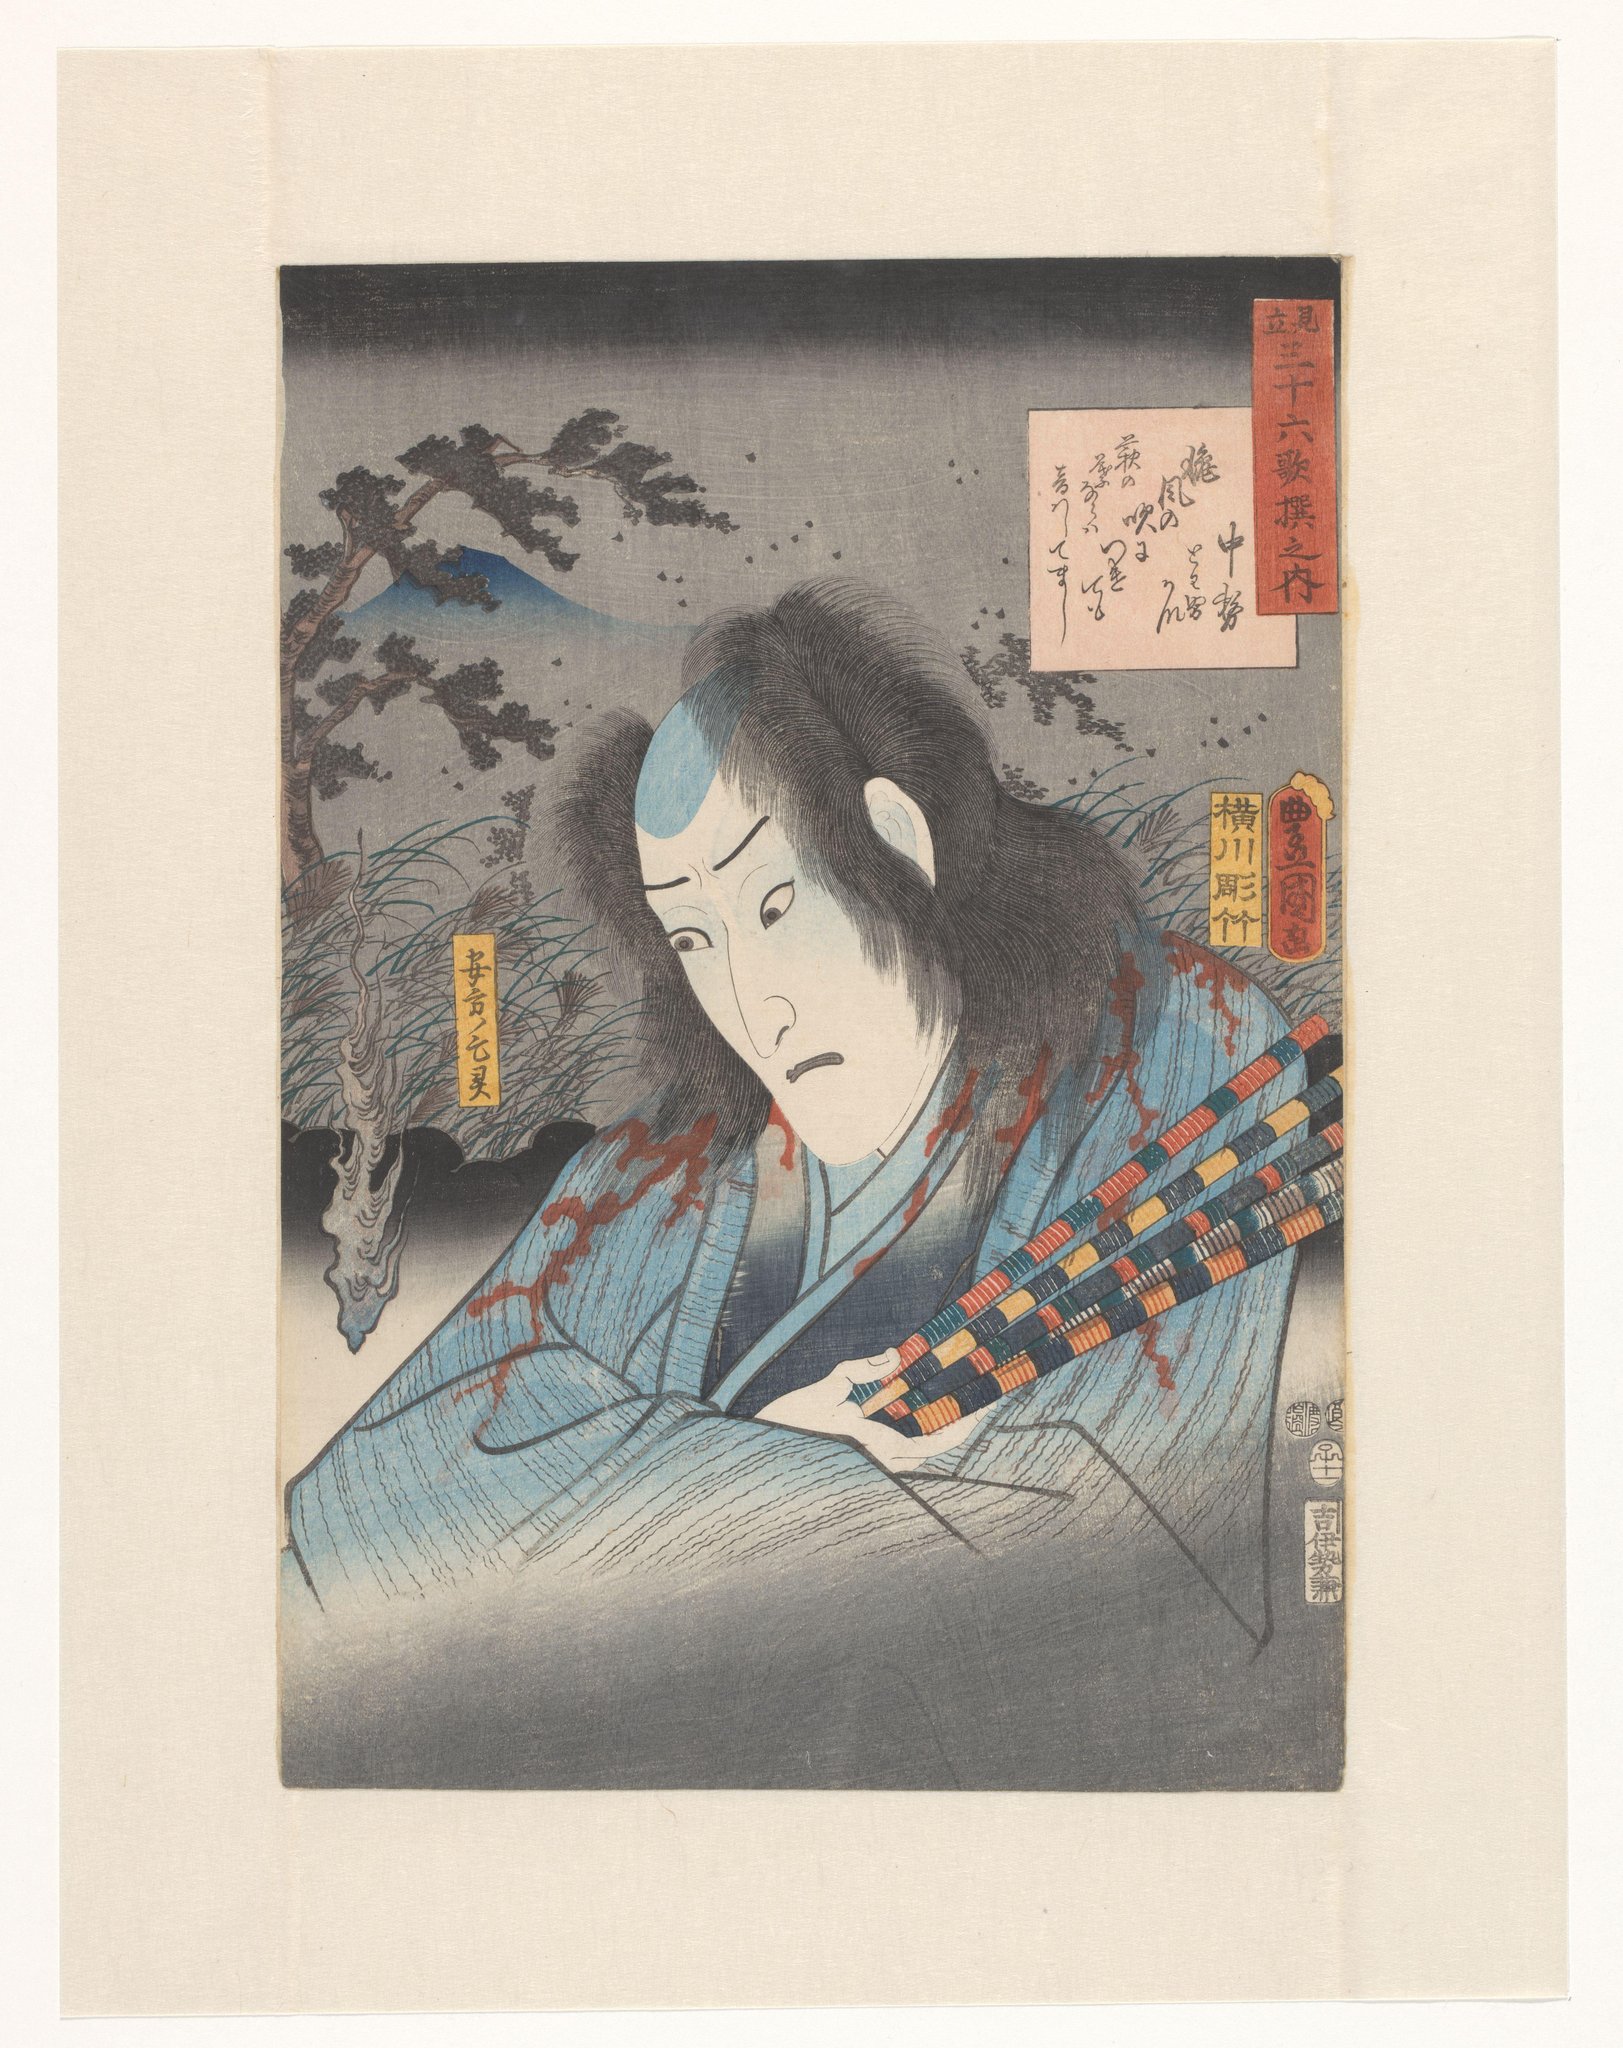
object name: print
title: Parodies of the 36 poets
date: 1811-1852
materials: paper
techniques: woodcut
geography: japan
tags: actor (on the stage), spirit, ghost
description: Kabuki acteur Onoe Kikugorô III als het spook Yasukata met bloed over zijn schouders en gekleurde stokjes in zijn handen. De blauwe make-up rond zijn ogen, zijn warrige haar en de vlammetjes naast hem, geven aan dat hier een spook is afgebeeld.